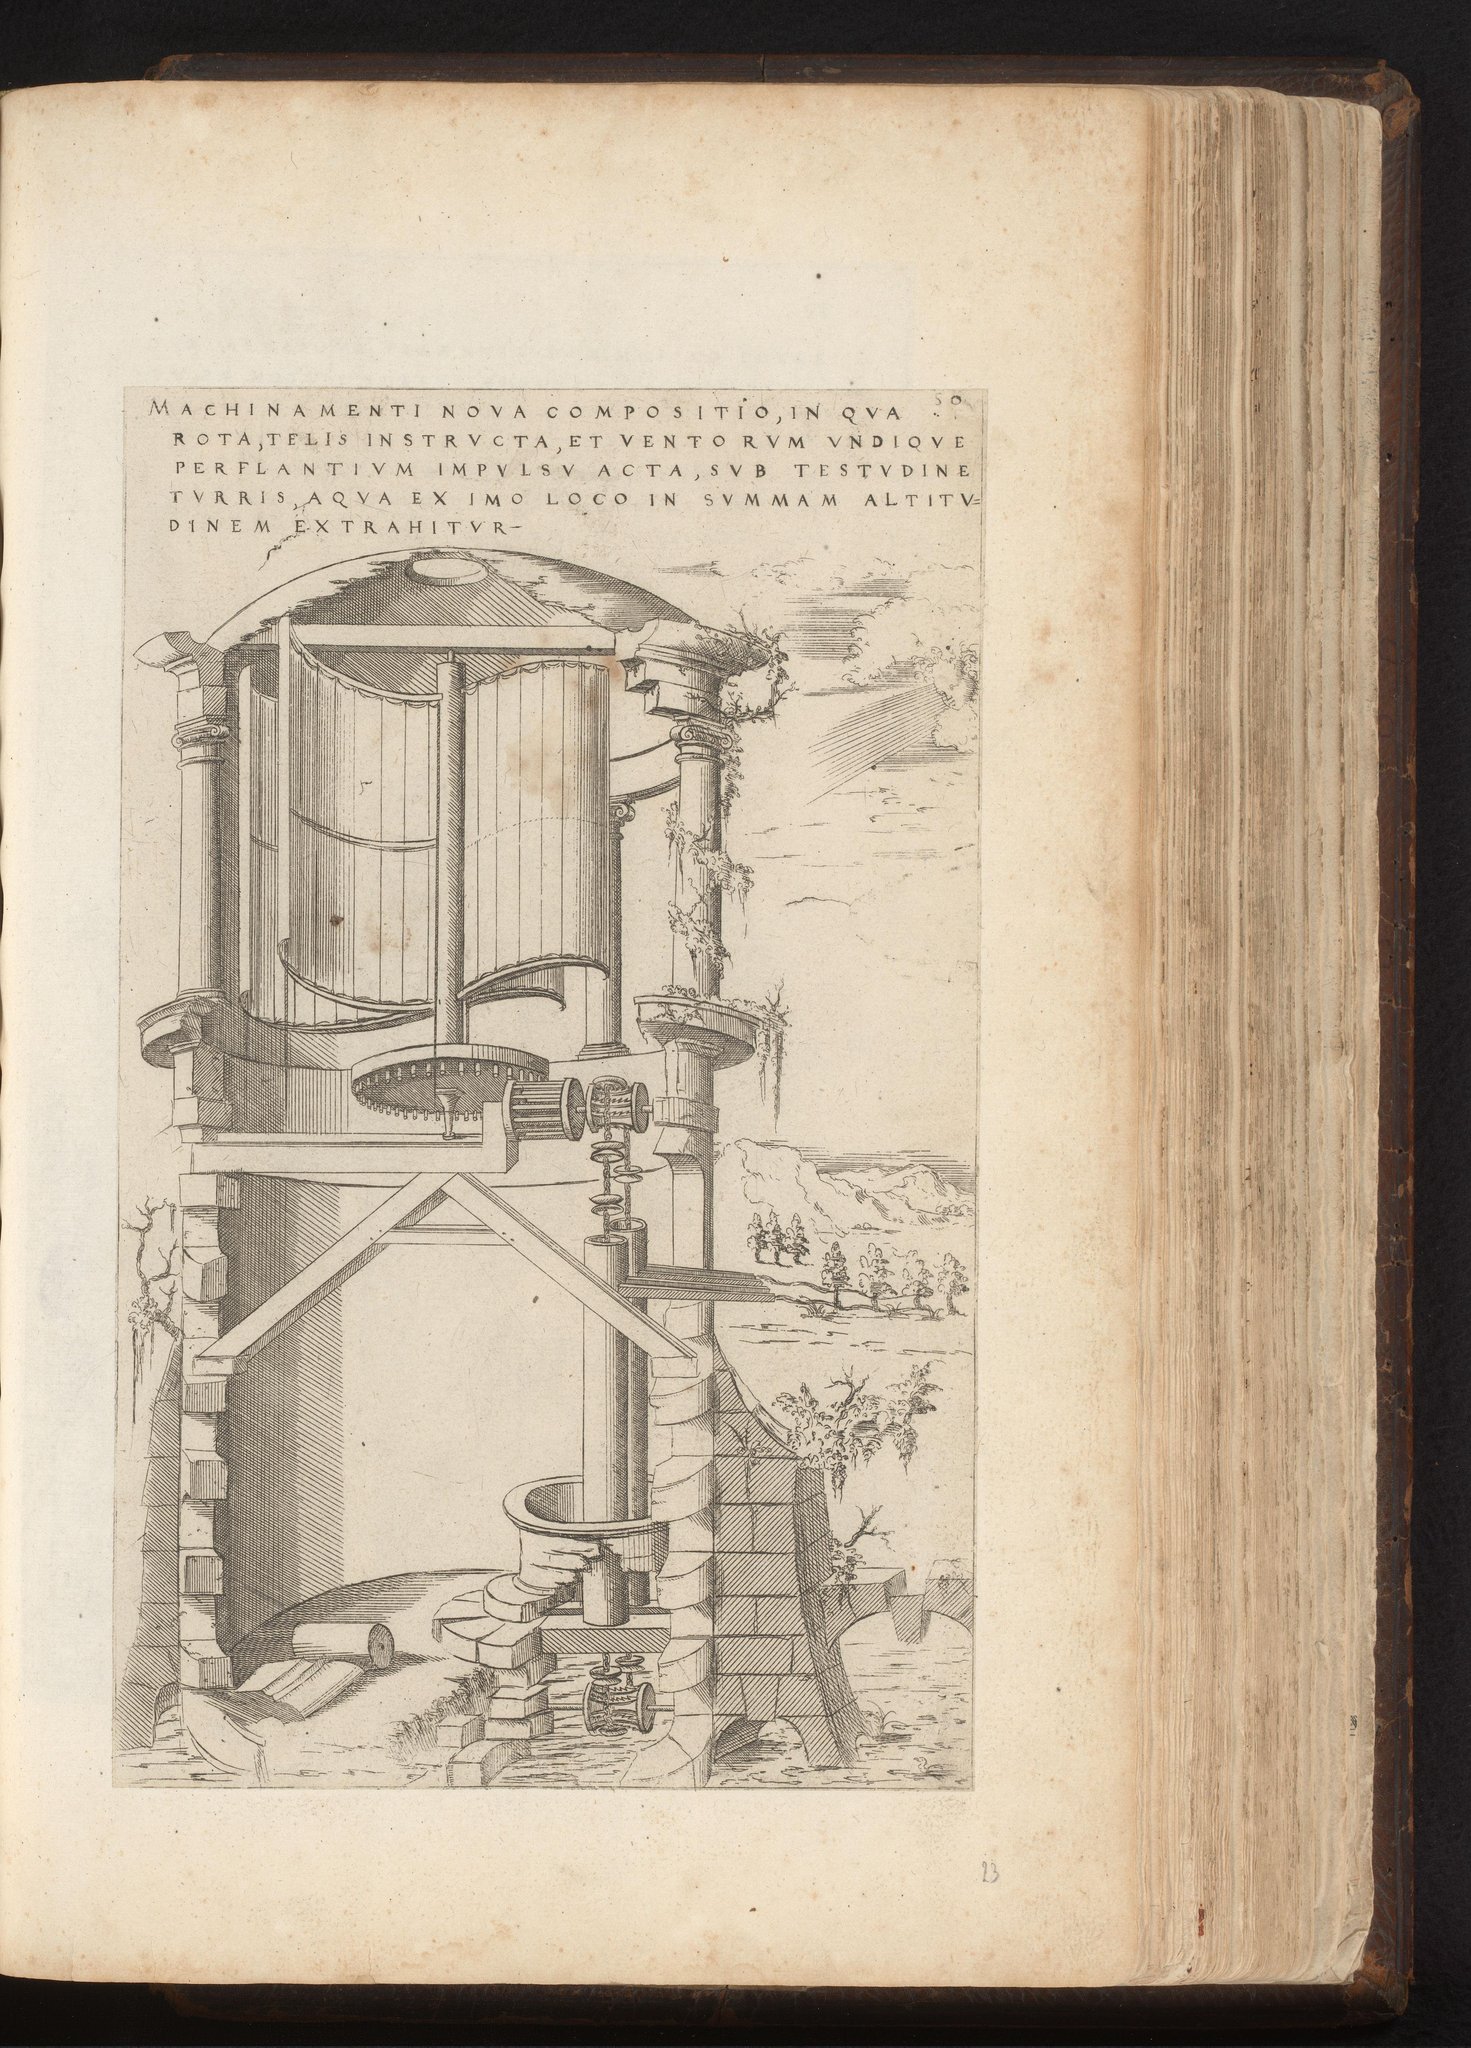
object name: print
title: Door de wind aangedreven mechanisme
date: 1579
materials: paper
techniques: etching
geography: lyon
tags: machine driven by wind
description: Prent uit: Besson, Jacques. Theatre des instrumens mathematiques & mechaniques. Lyon: Barthelemy Vincent, 1579. Prent voor het eerst verschenen in de eerste editie van ca. 1569.